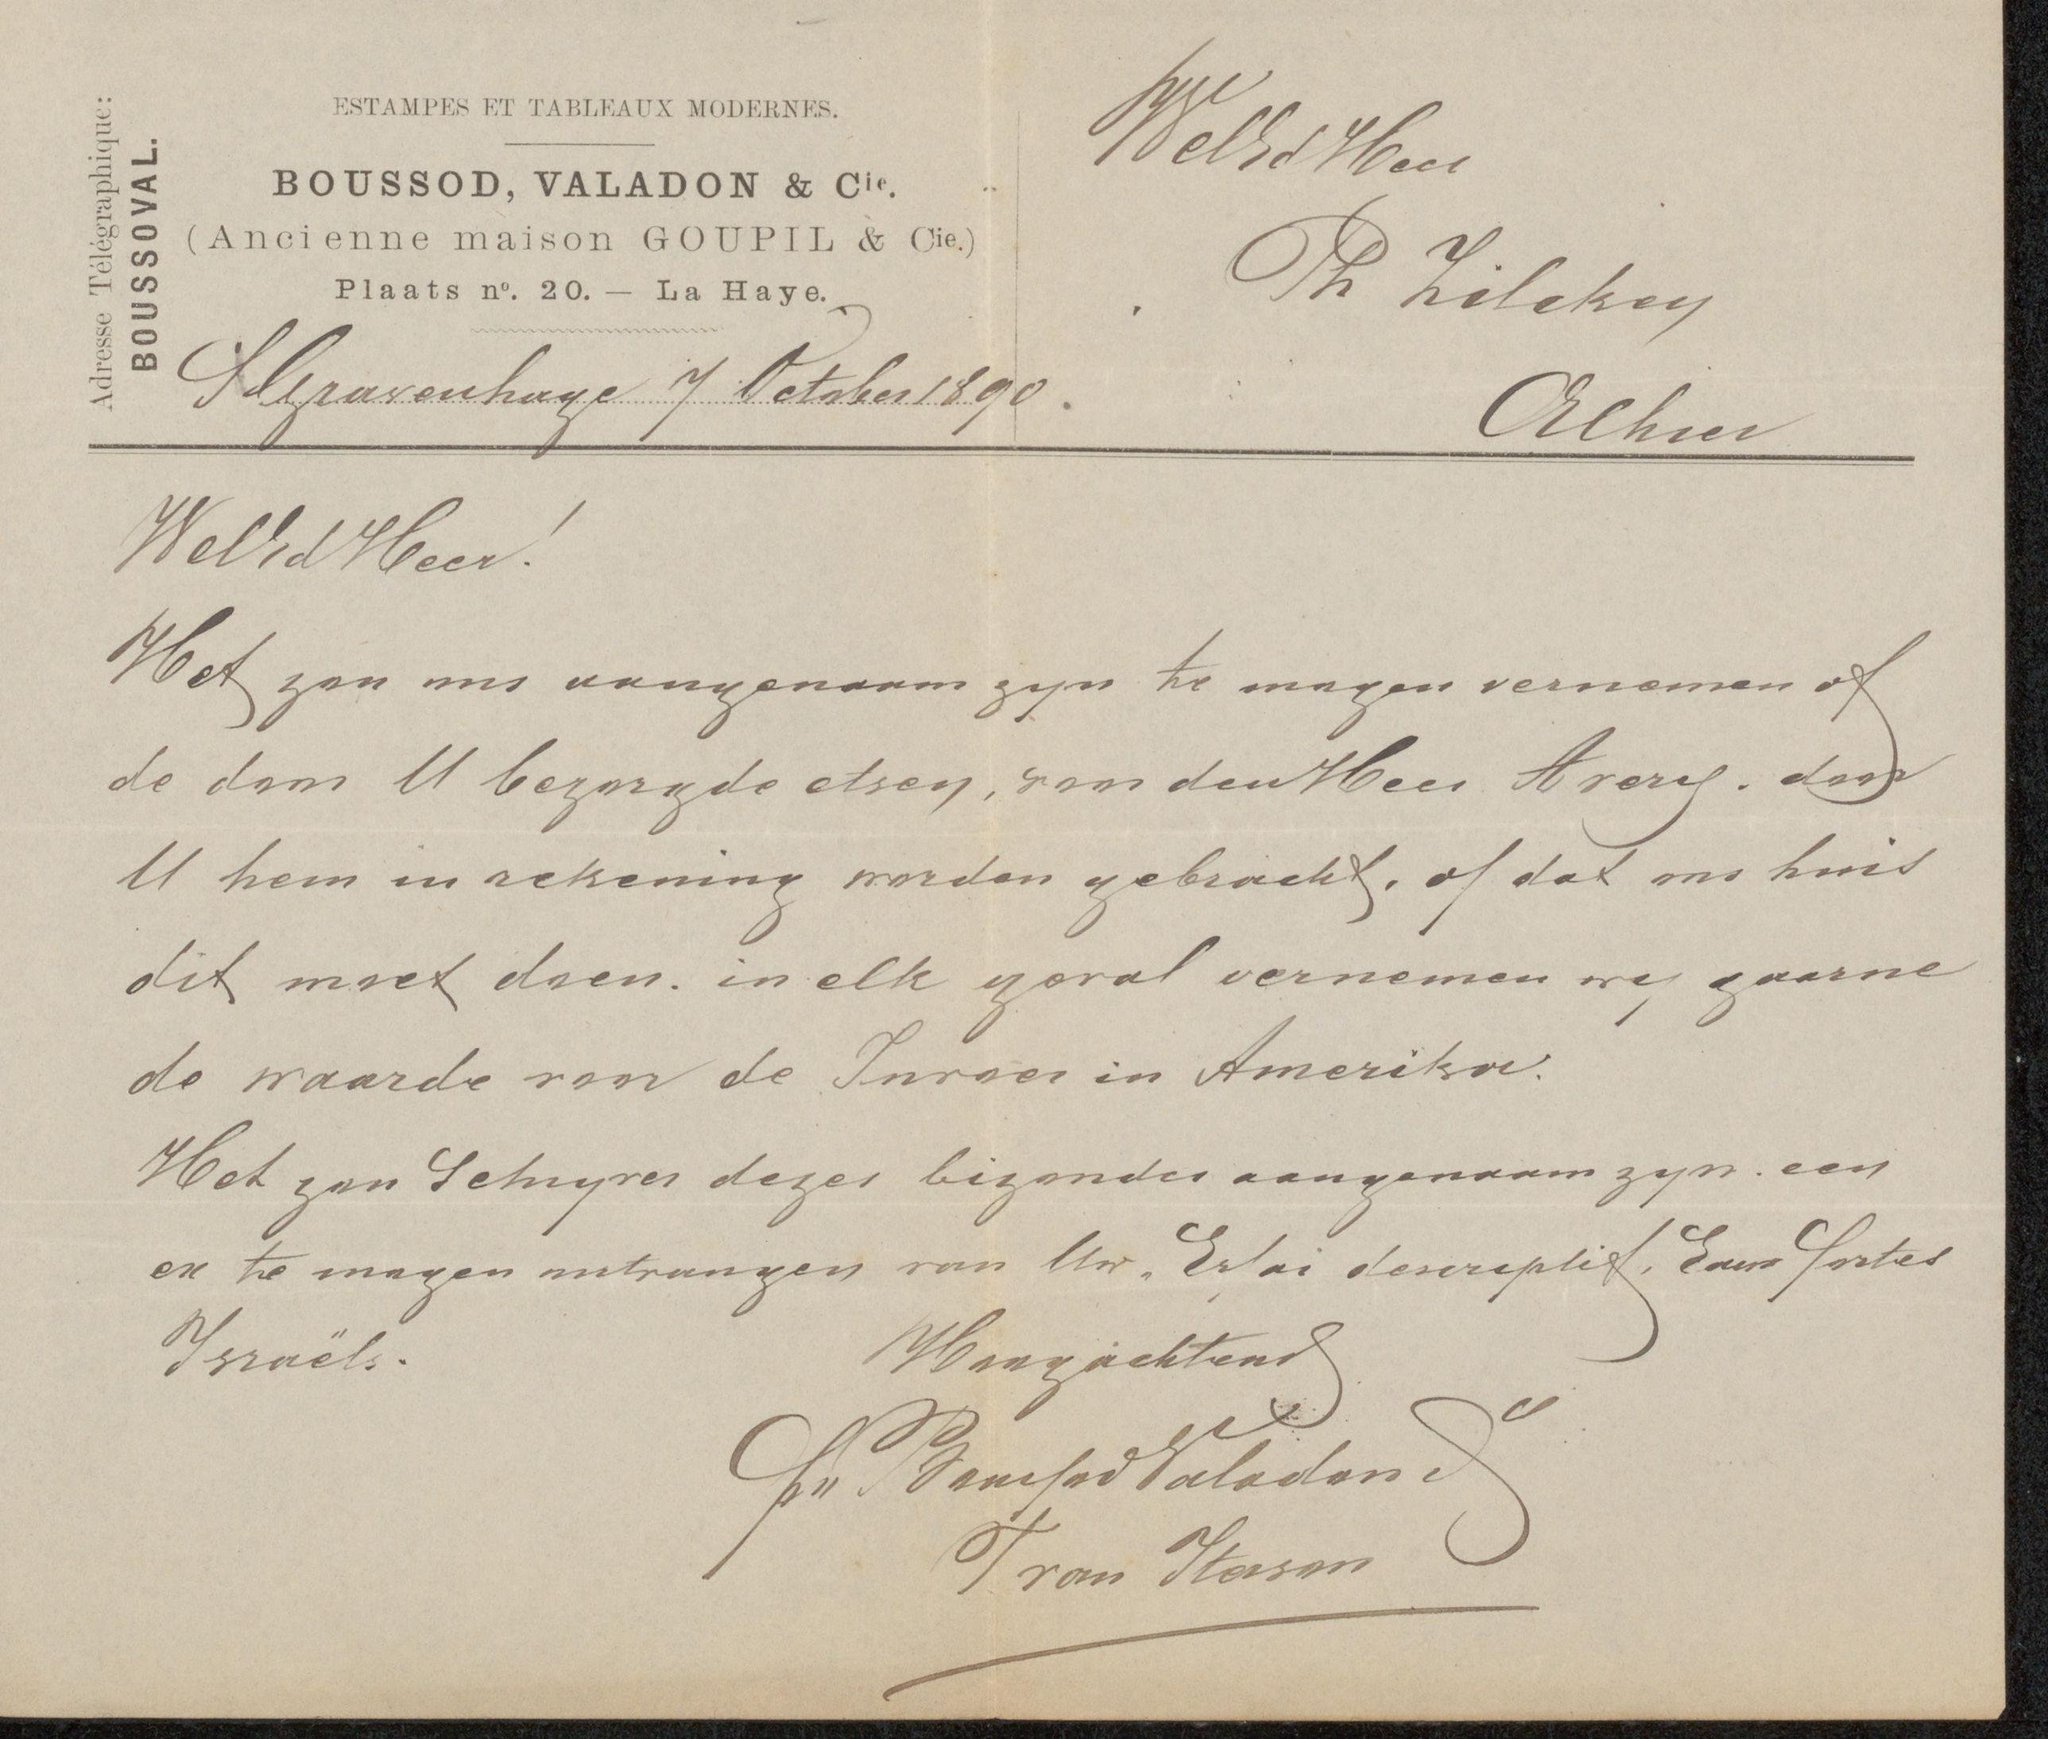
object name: letter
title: Brief aan Philip Zilcken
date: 1890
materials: ink, paper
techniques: pen, printing, writing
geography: the hague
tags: new york (city), samuel putnam avery, the hague, painter, draughtsman, philip zilcken, art trade, art shop, the graphic arts, art collecting